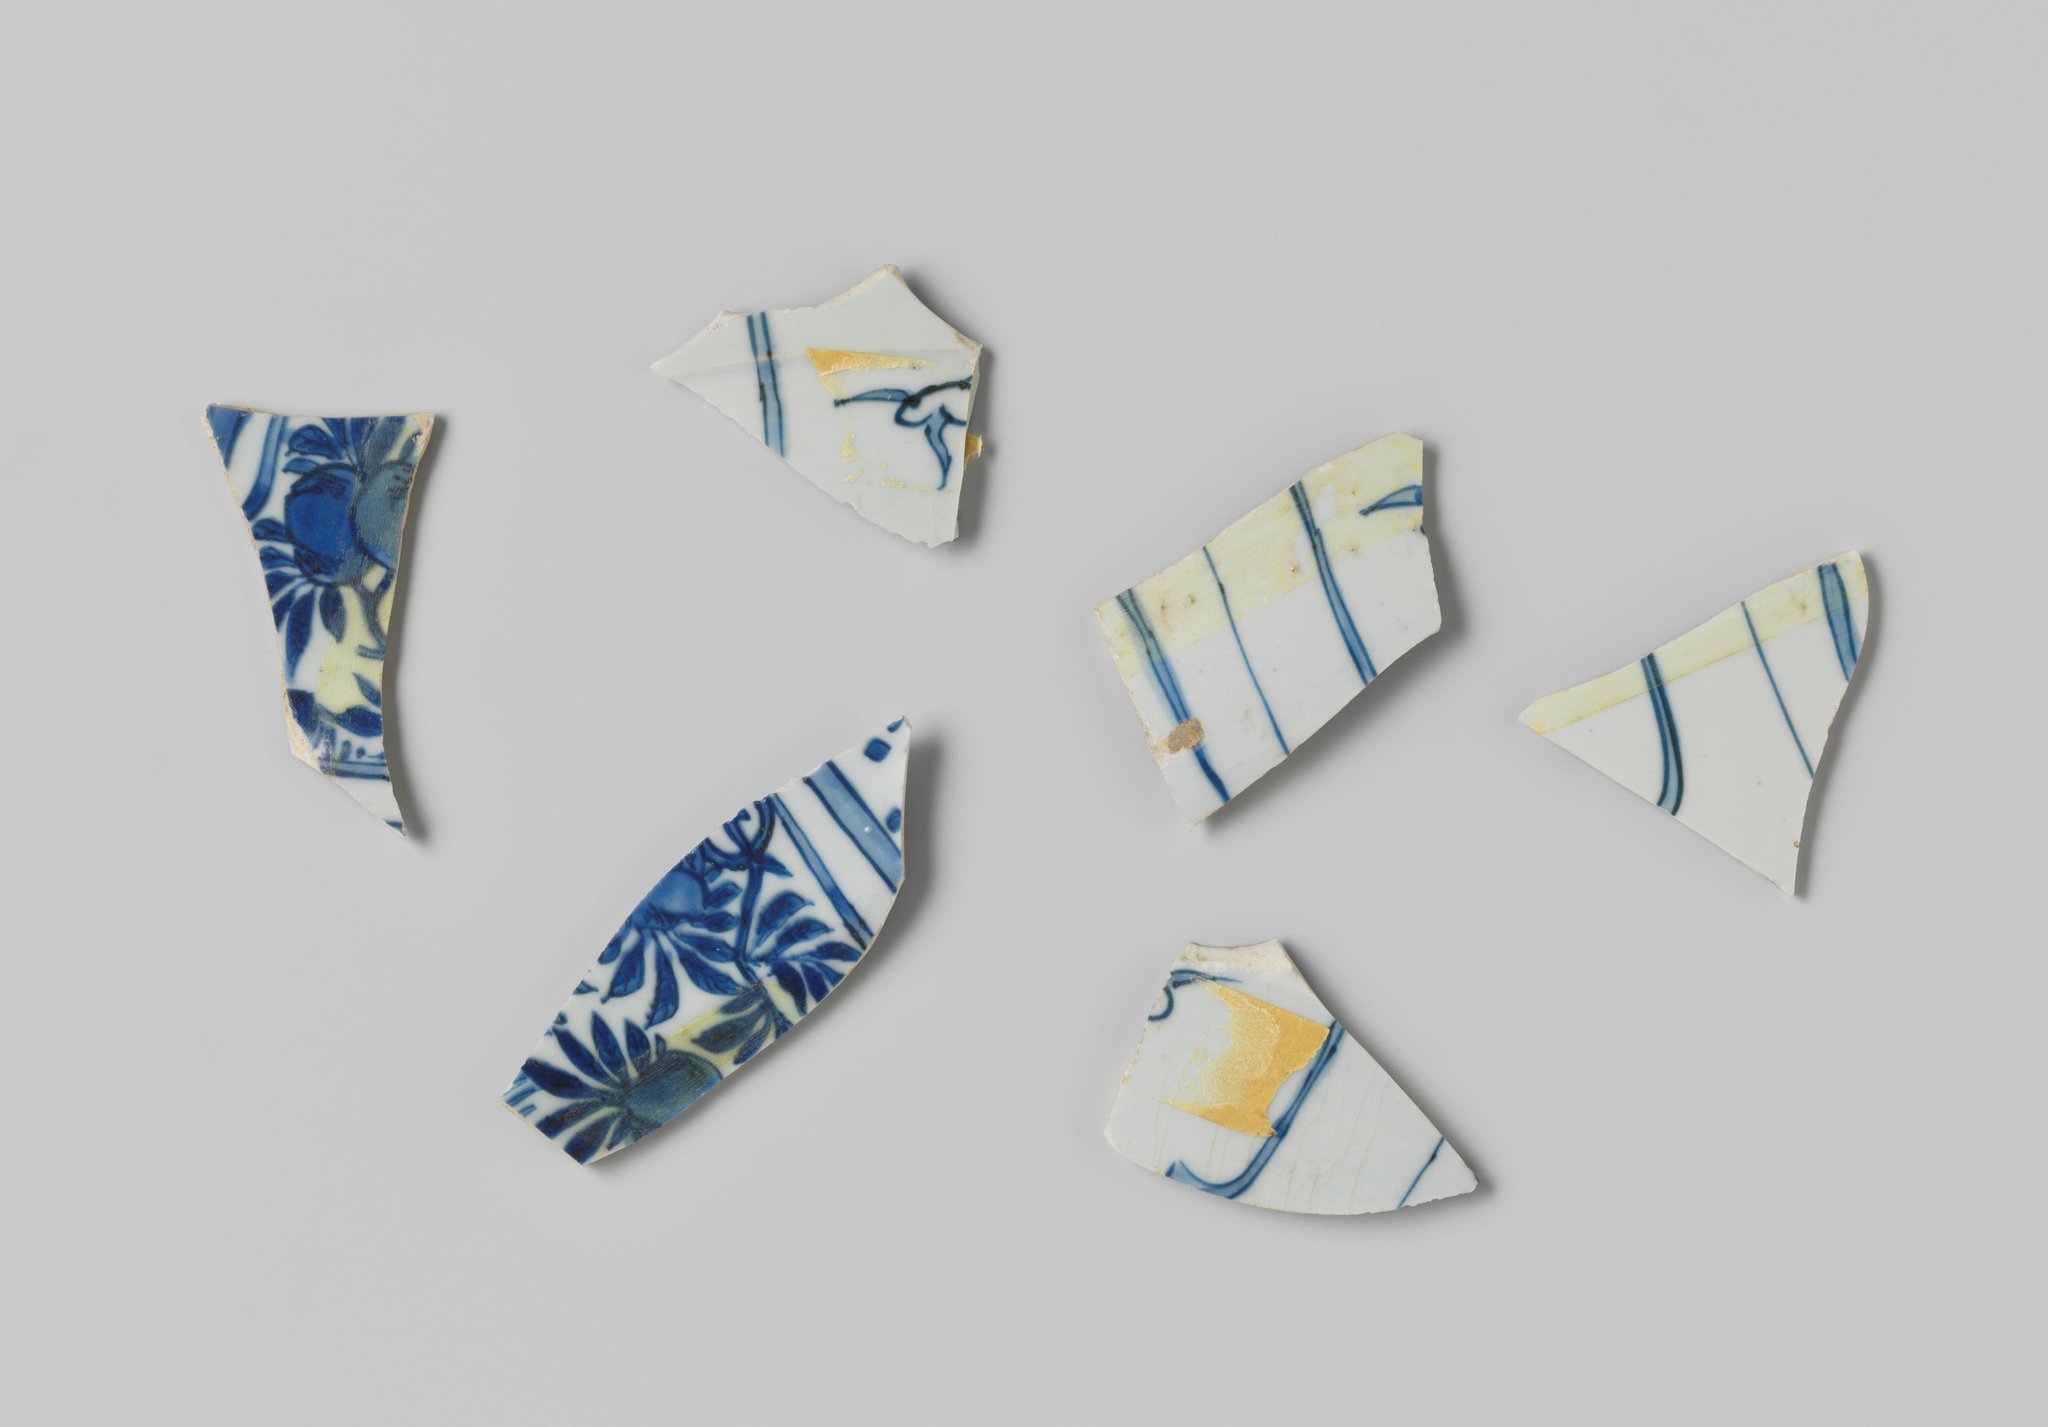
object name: plate dish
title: Scherven van borden uit V.O.C.-schip de 'Witte Leeuw'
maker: Anonymous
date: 1613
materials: bone china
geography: jingdezhen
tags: verenigde oostindische compagnie, sint-helena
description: Scherven van borden uit V.O.C.-schip de 'Witte Leeuw'.